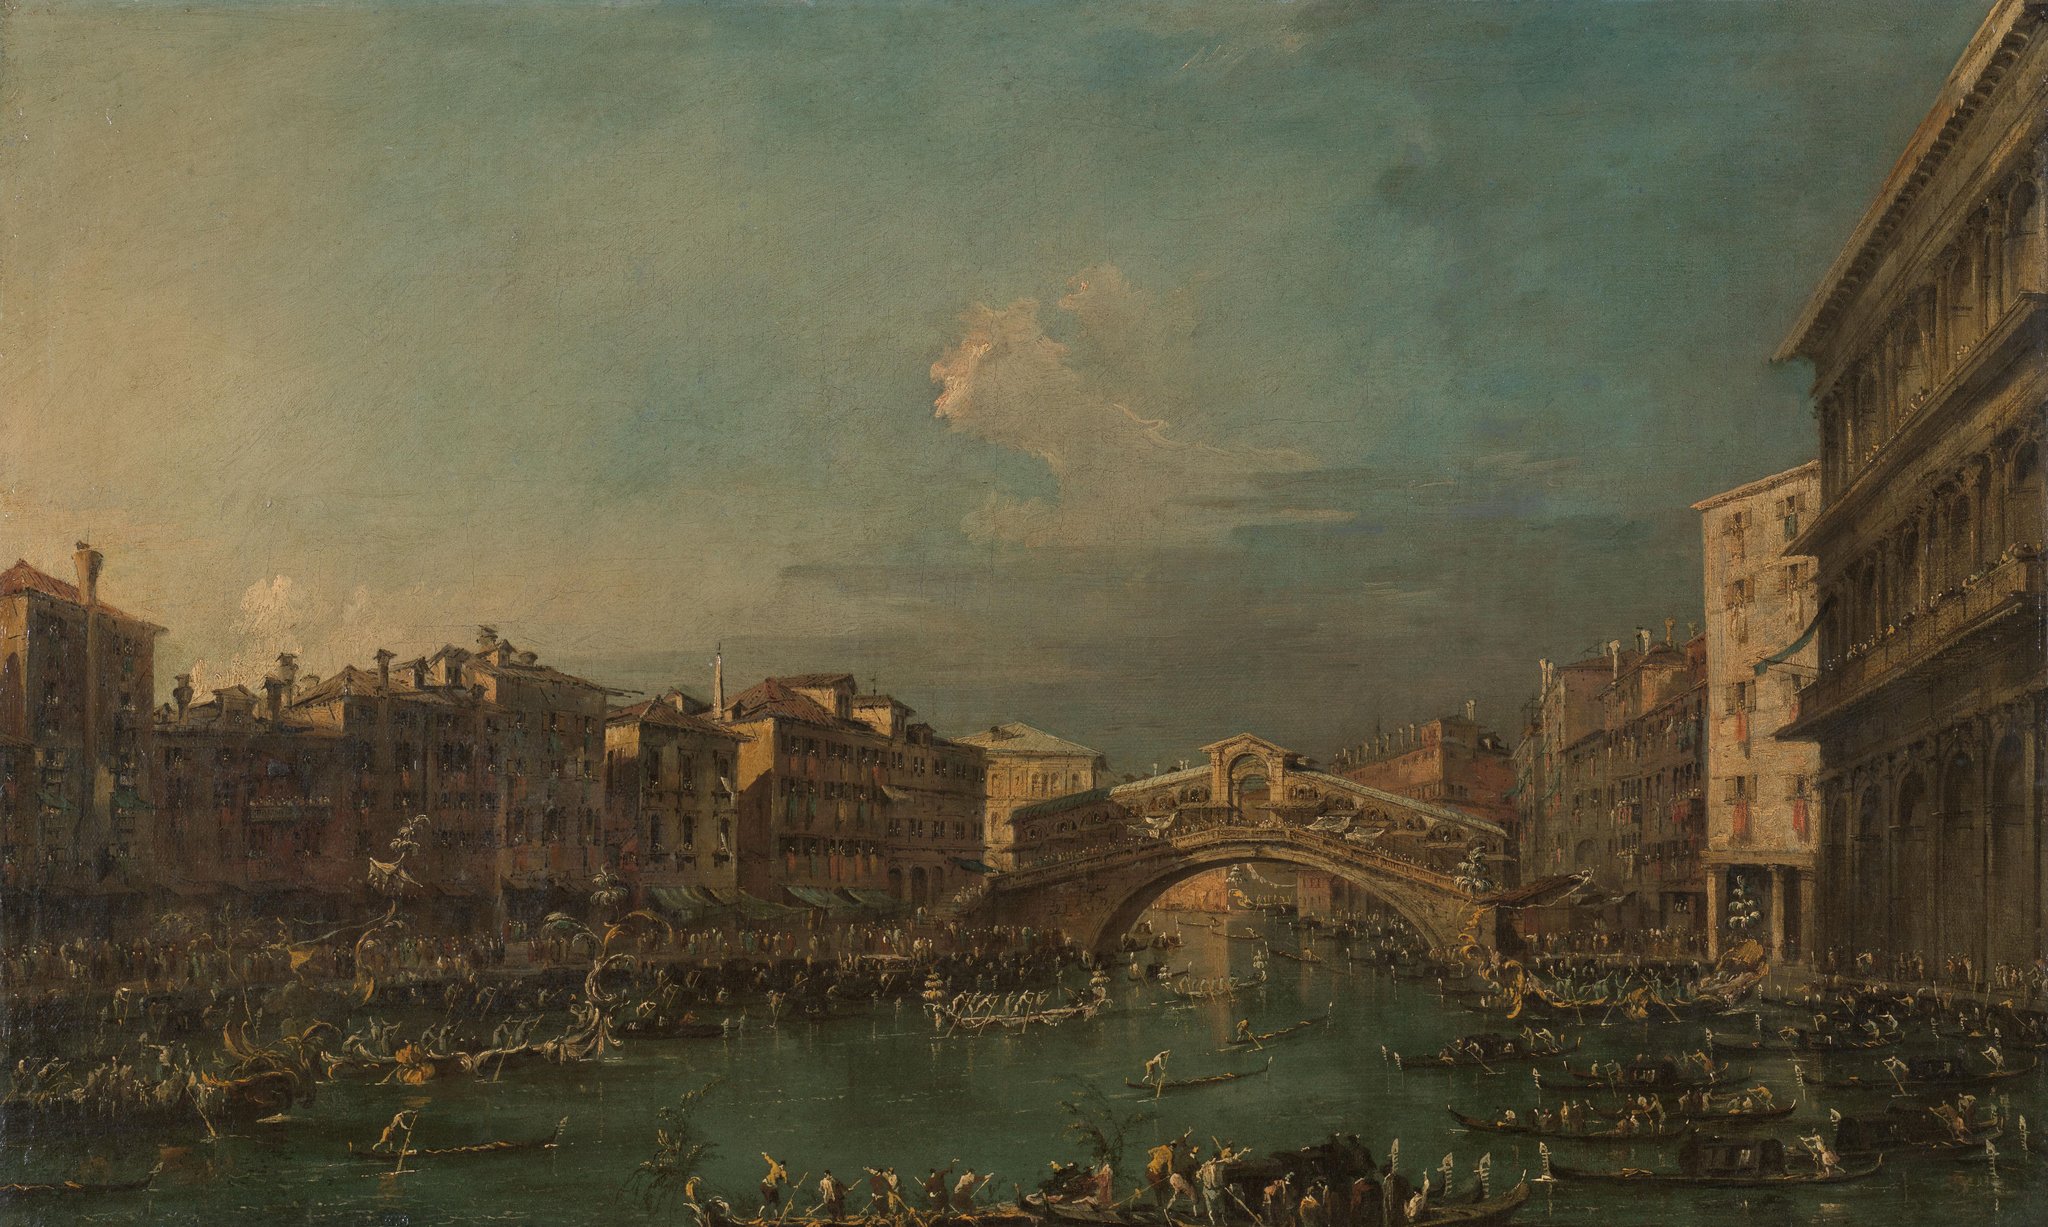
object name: painting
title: Regatta on the Grand Canal, near the Rialto Bridge, Venice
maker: francesco guardi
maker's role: draughtsman, painter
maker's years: 1712-1792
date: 1780-1793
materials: canvas, oil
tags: public festivities - aa - festivities on the water, oaring, sculling, bridge in city across river, canal, etc.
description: Gezicht over het Canal Grande ter hoogte van de Rialtobrug te Venetië waar een regatta plaatsvindt. Op het water vele kleine bootjes en feestende toeschouwers op de kades en in de huizen gelegen aan het kanaal.